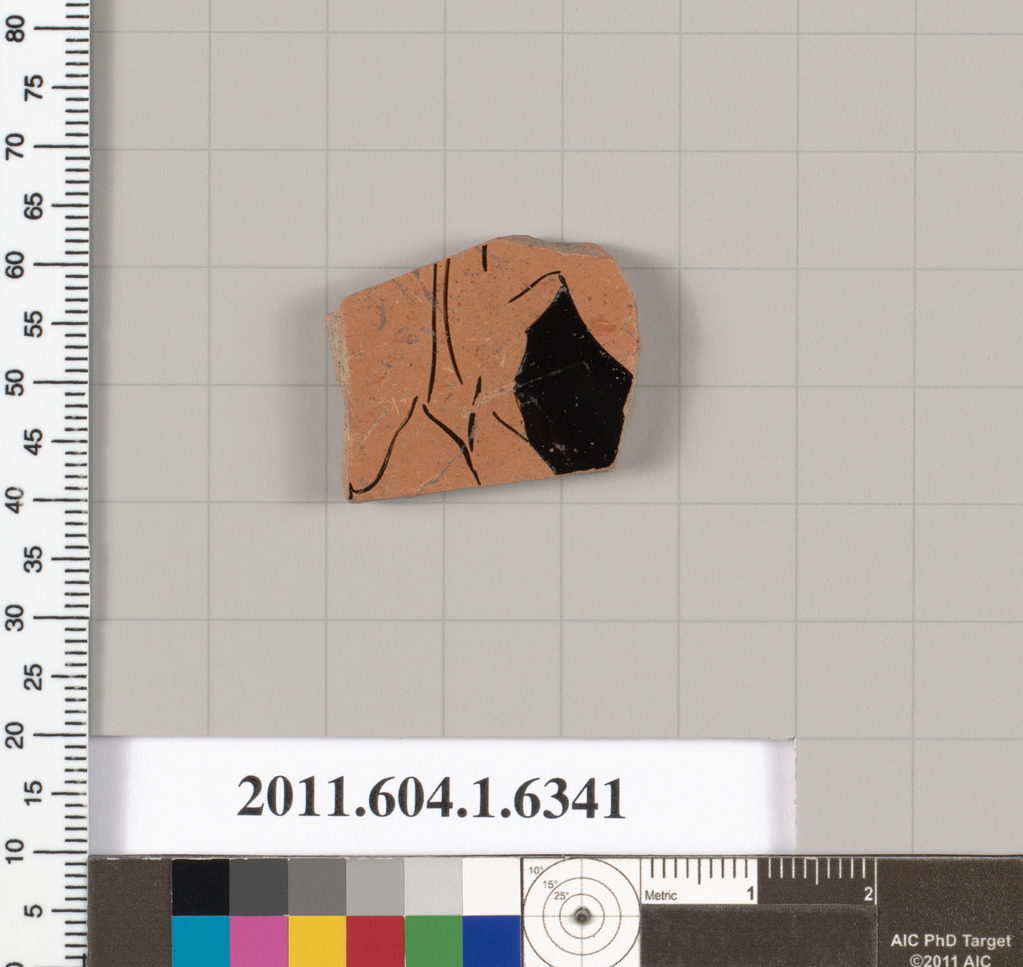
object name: kylix fragment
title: Terracotta fragment of a kylix (drinking cup)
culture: greek, attic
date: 500-480 BCE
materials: terracotta